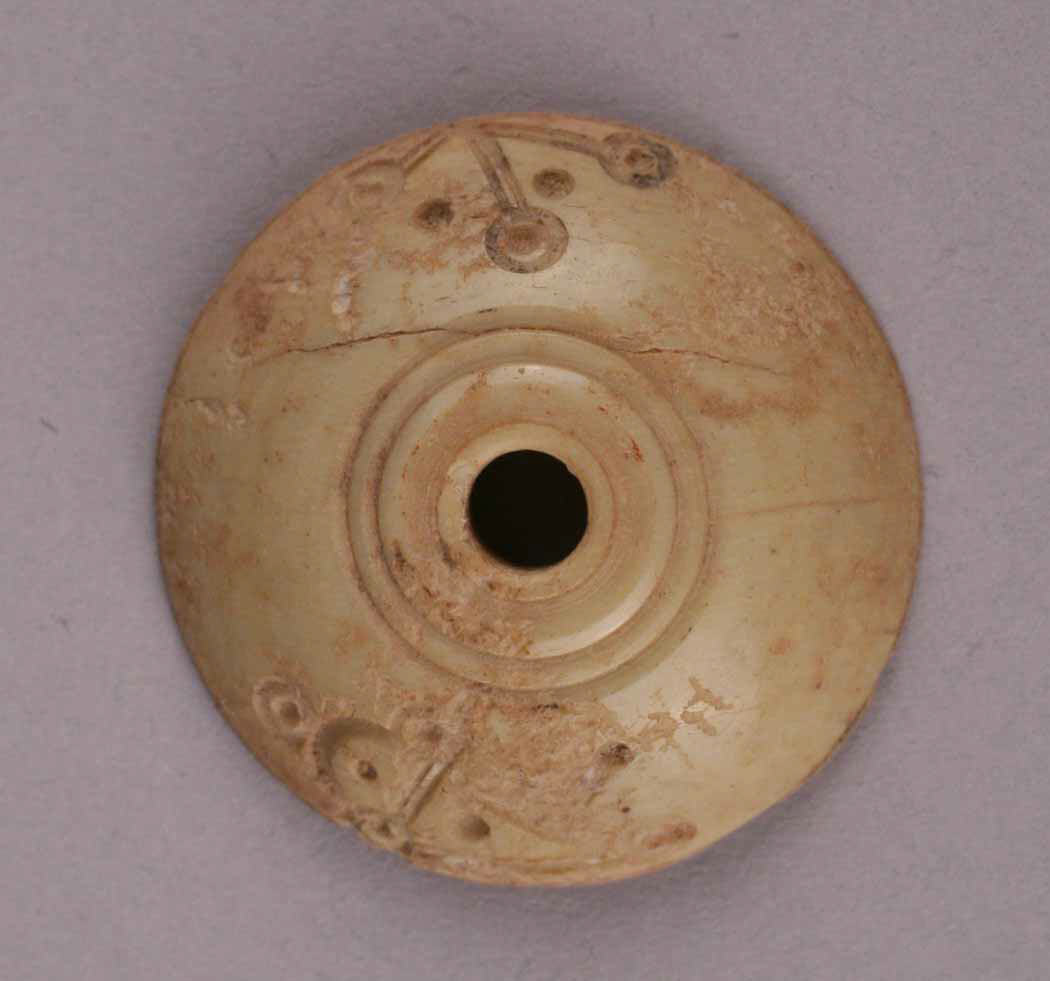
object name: button or bead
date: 801-1000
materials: bone, paint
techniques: incising, inlay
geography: iran